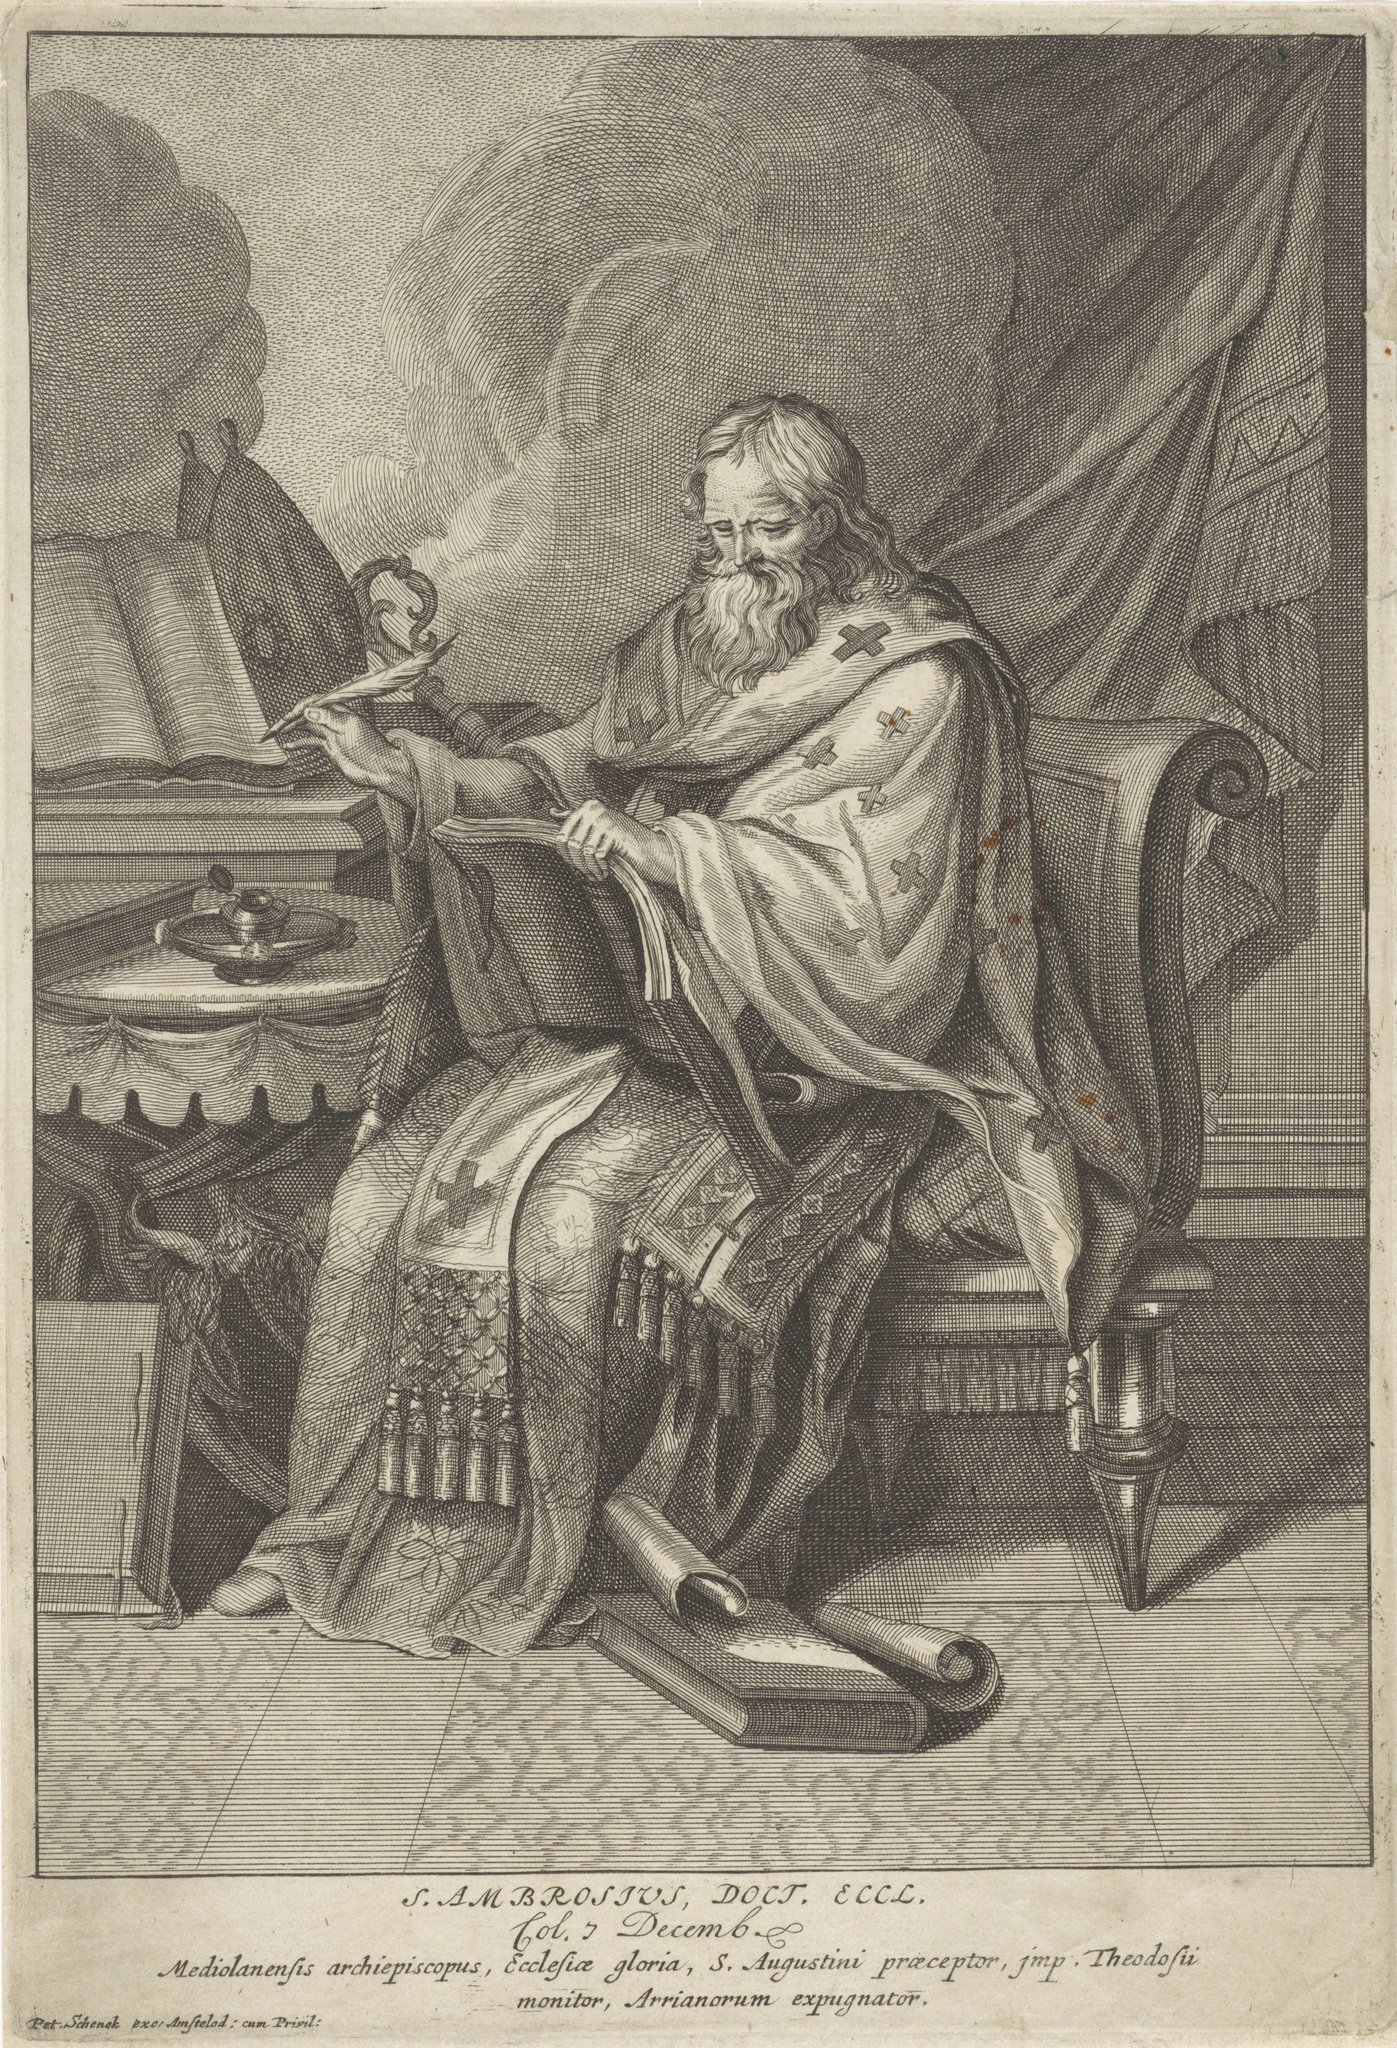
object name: print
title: H. Ambrosius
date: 1675-1711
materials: paper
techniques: engraving, etching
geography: amsterdam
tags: ambrose, bishop of milan; possible attributes: beehive, cradle with baby, three-knotted scourge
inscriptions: collector's mark: Lugt 2228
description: De heilige Ambrosius, bisschop van Milaan, zittend bij een tafel, met een boek in de ene hand en een schrijfveer in de andere hand. Op tafel zijn bisschopsmijter en daarnaast zijn staf.